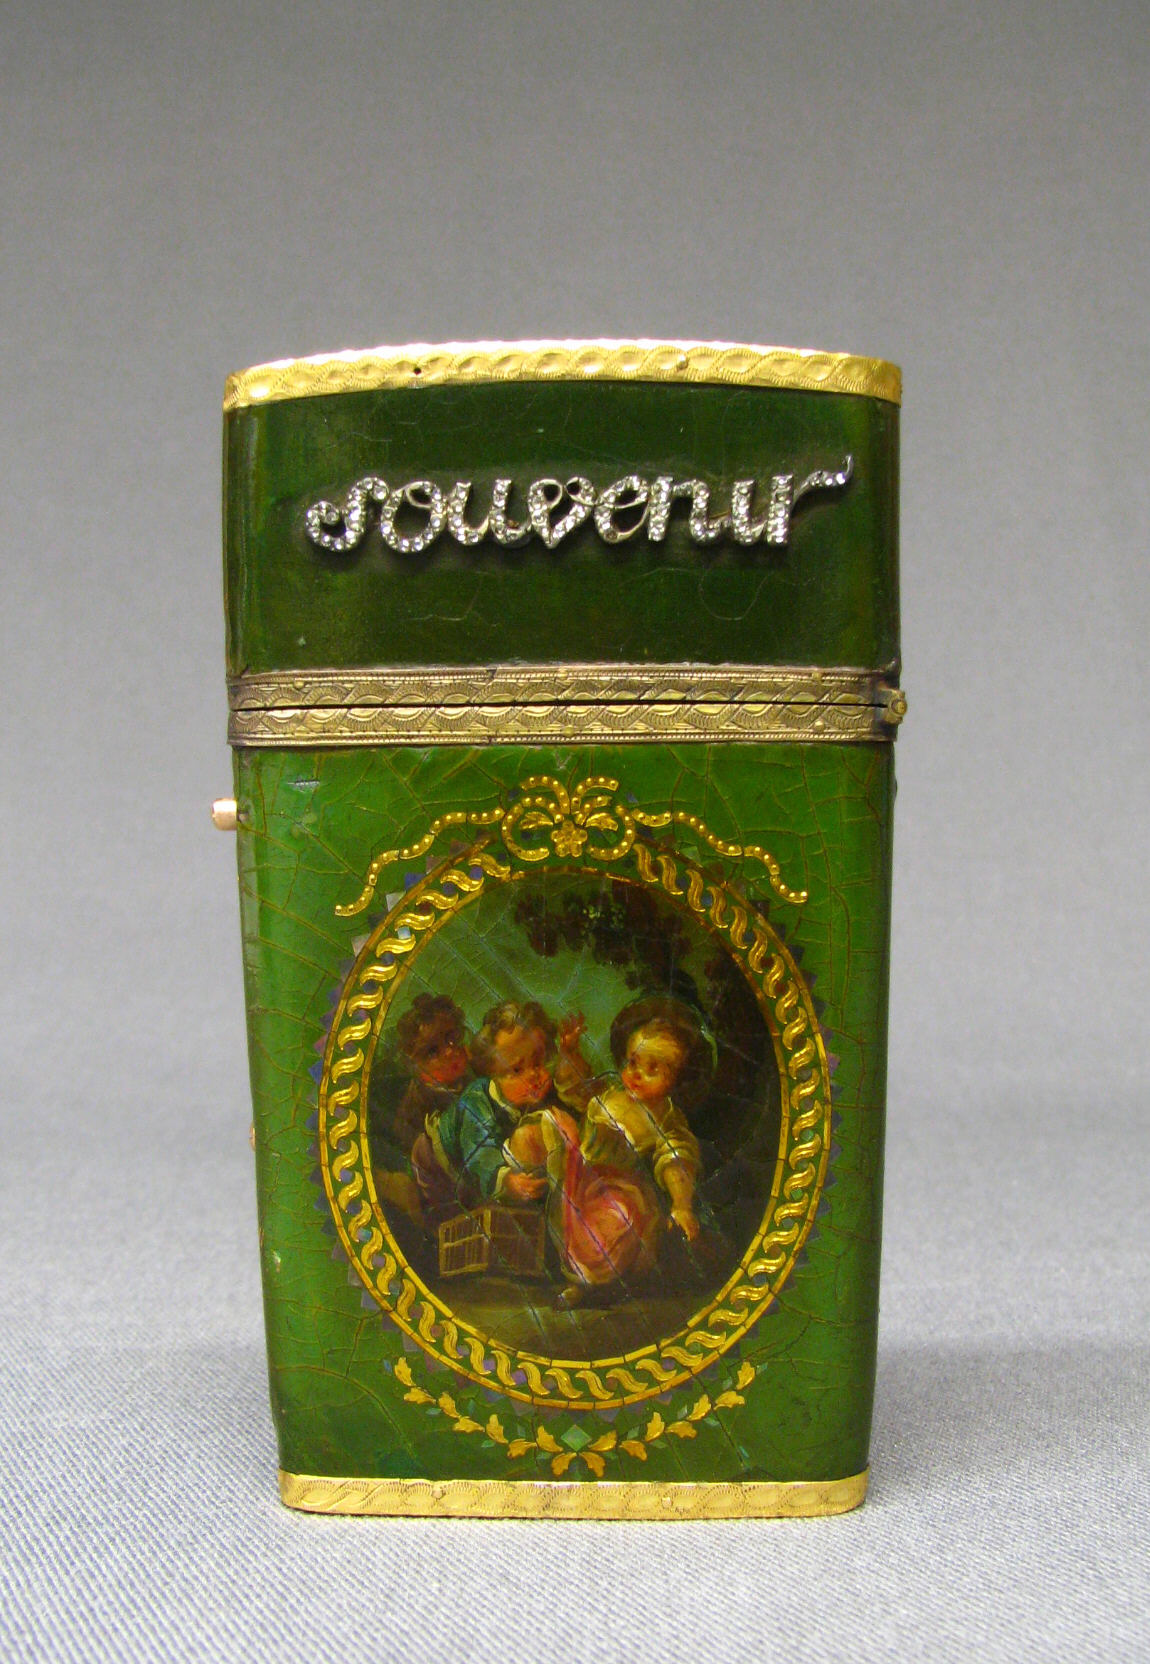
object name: souvenir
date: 1774-1780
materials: diamond, gold, ivory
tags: children